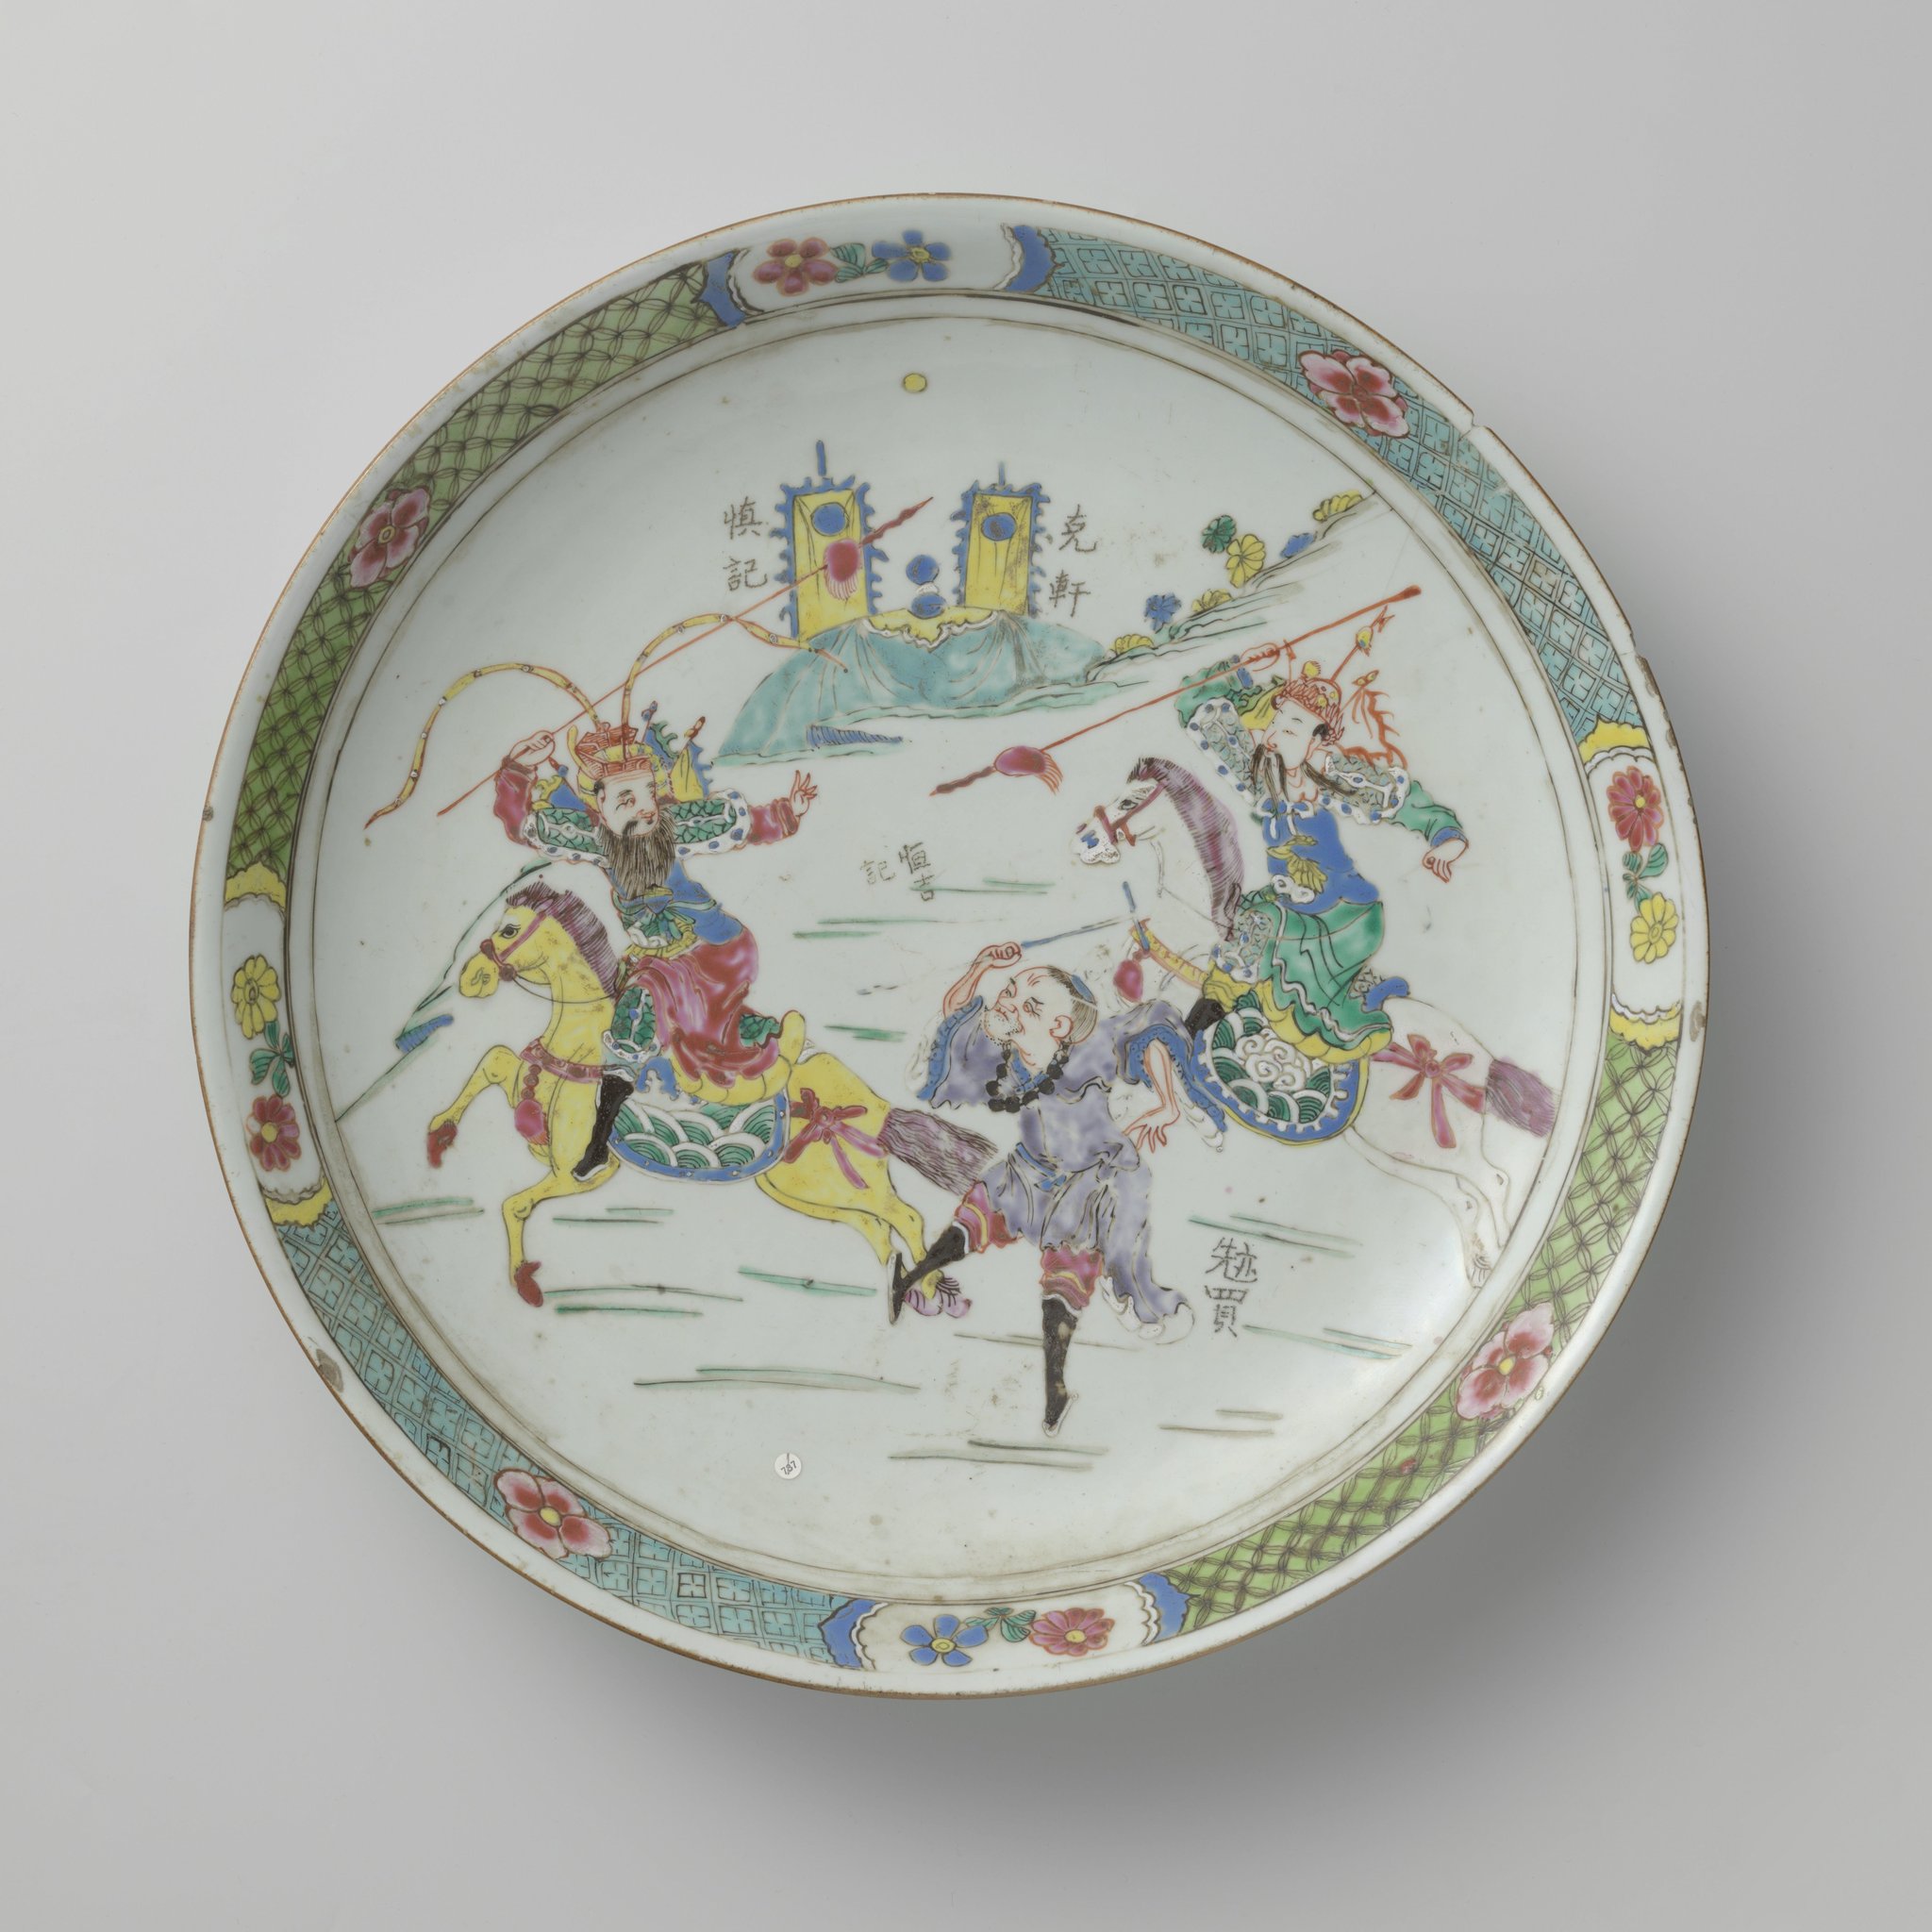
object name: platter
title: Saucer dish with two warriors on horseback and a man on foot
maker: Anonymous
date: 1720-1730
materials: glaze, paint, porcelain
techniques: firing, turning, vitrification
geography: china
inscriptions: inscription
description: Schotel, famille verte met rose, twee krijgslieden te paard en een te voet in veel kleuren .